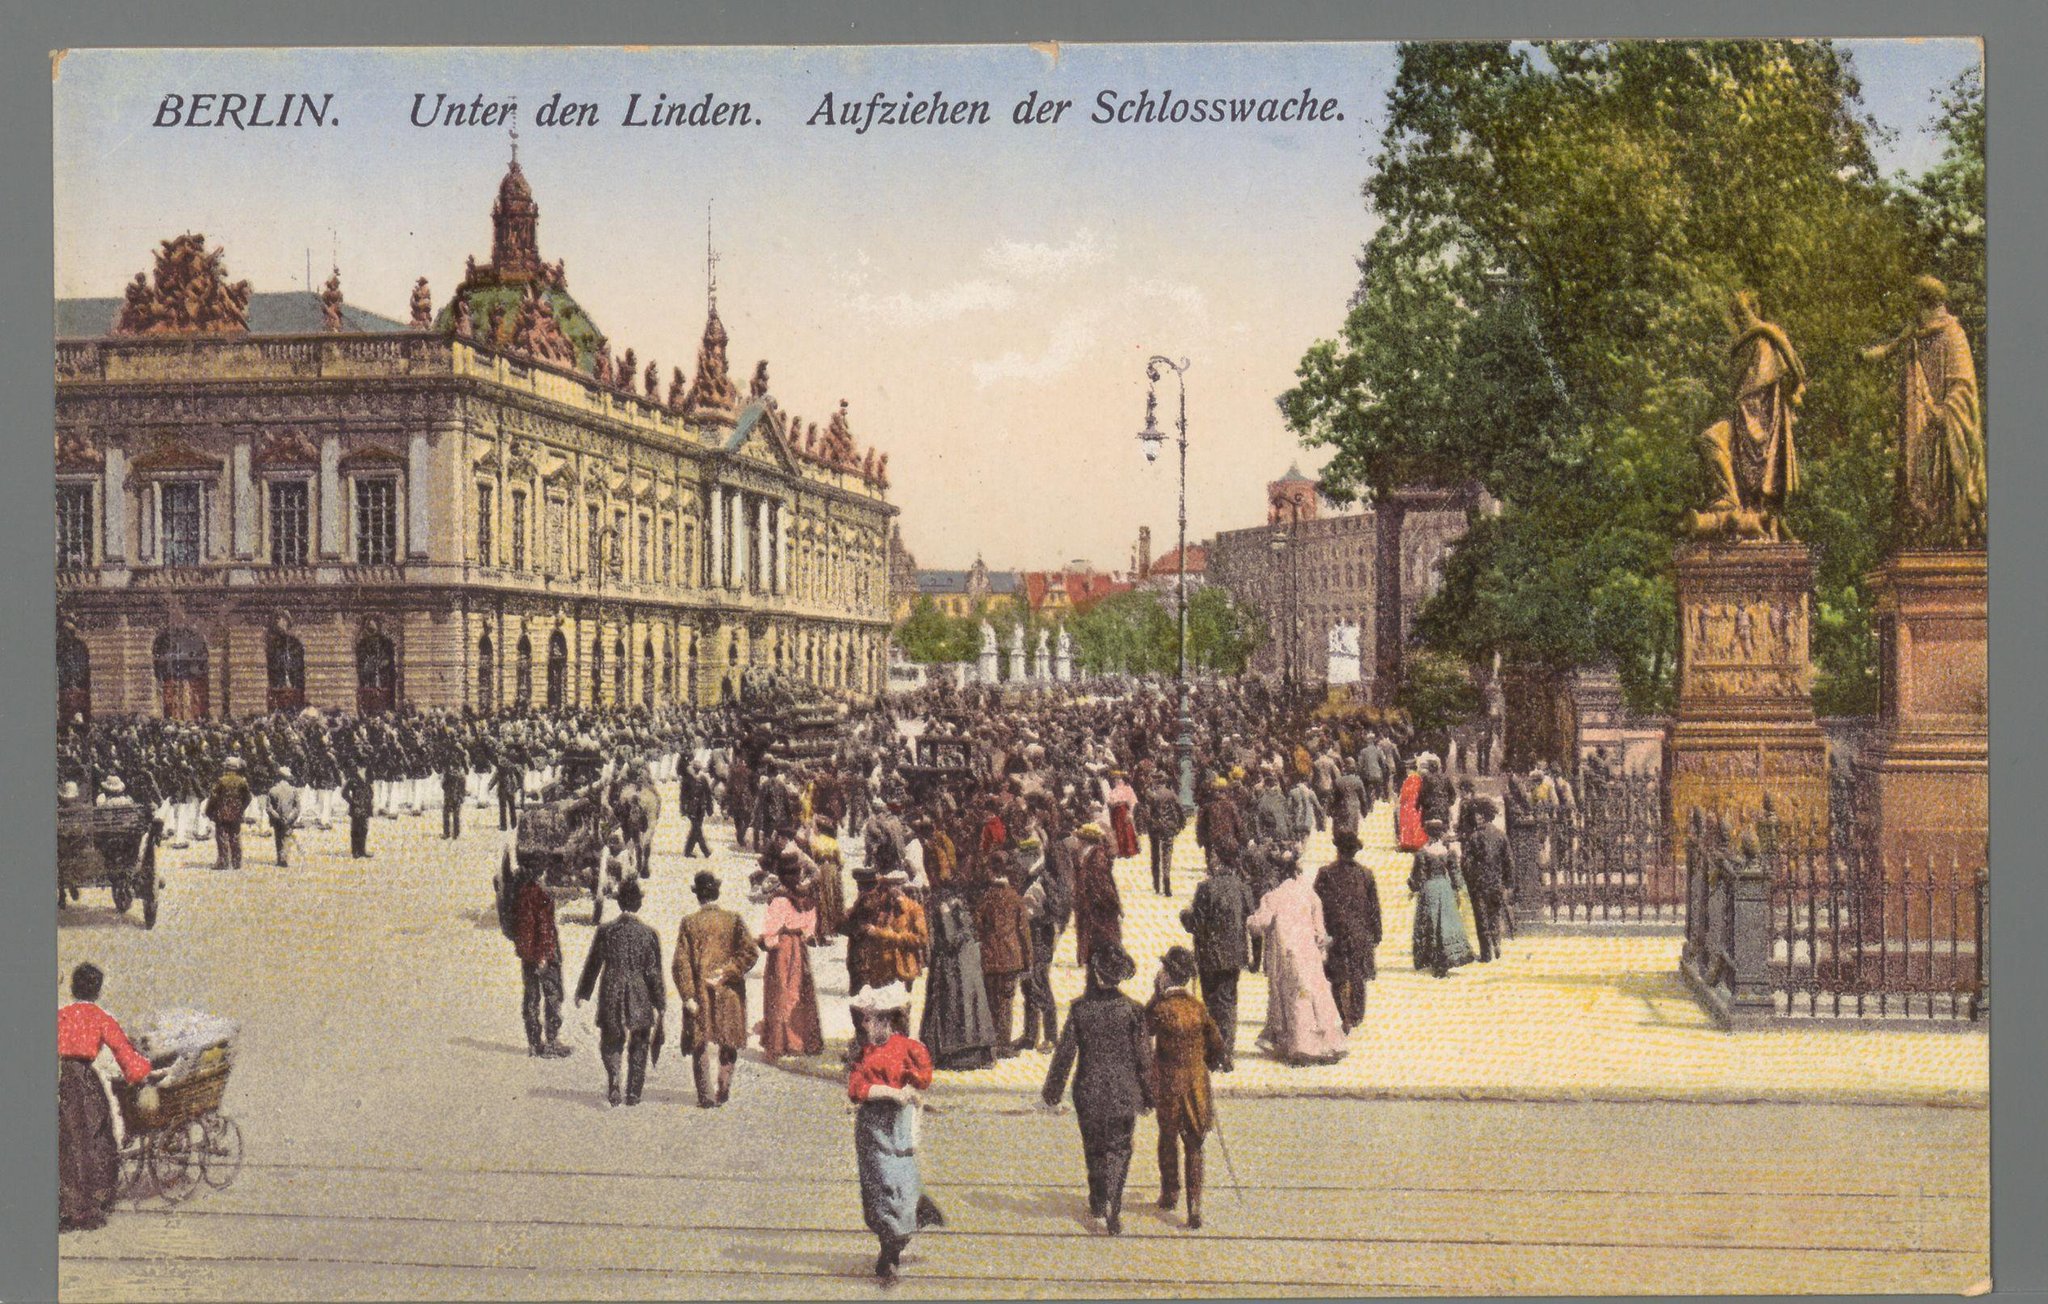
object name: ansichtkaart, prentbriefkaart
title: Berlin. Unter den Linden. Aufziehen der Schlosswache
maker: Anonymous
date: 1905-1930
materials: cardboard, photographic process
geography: berlin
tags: castle, changing the guard